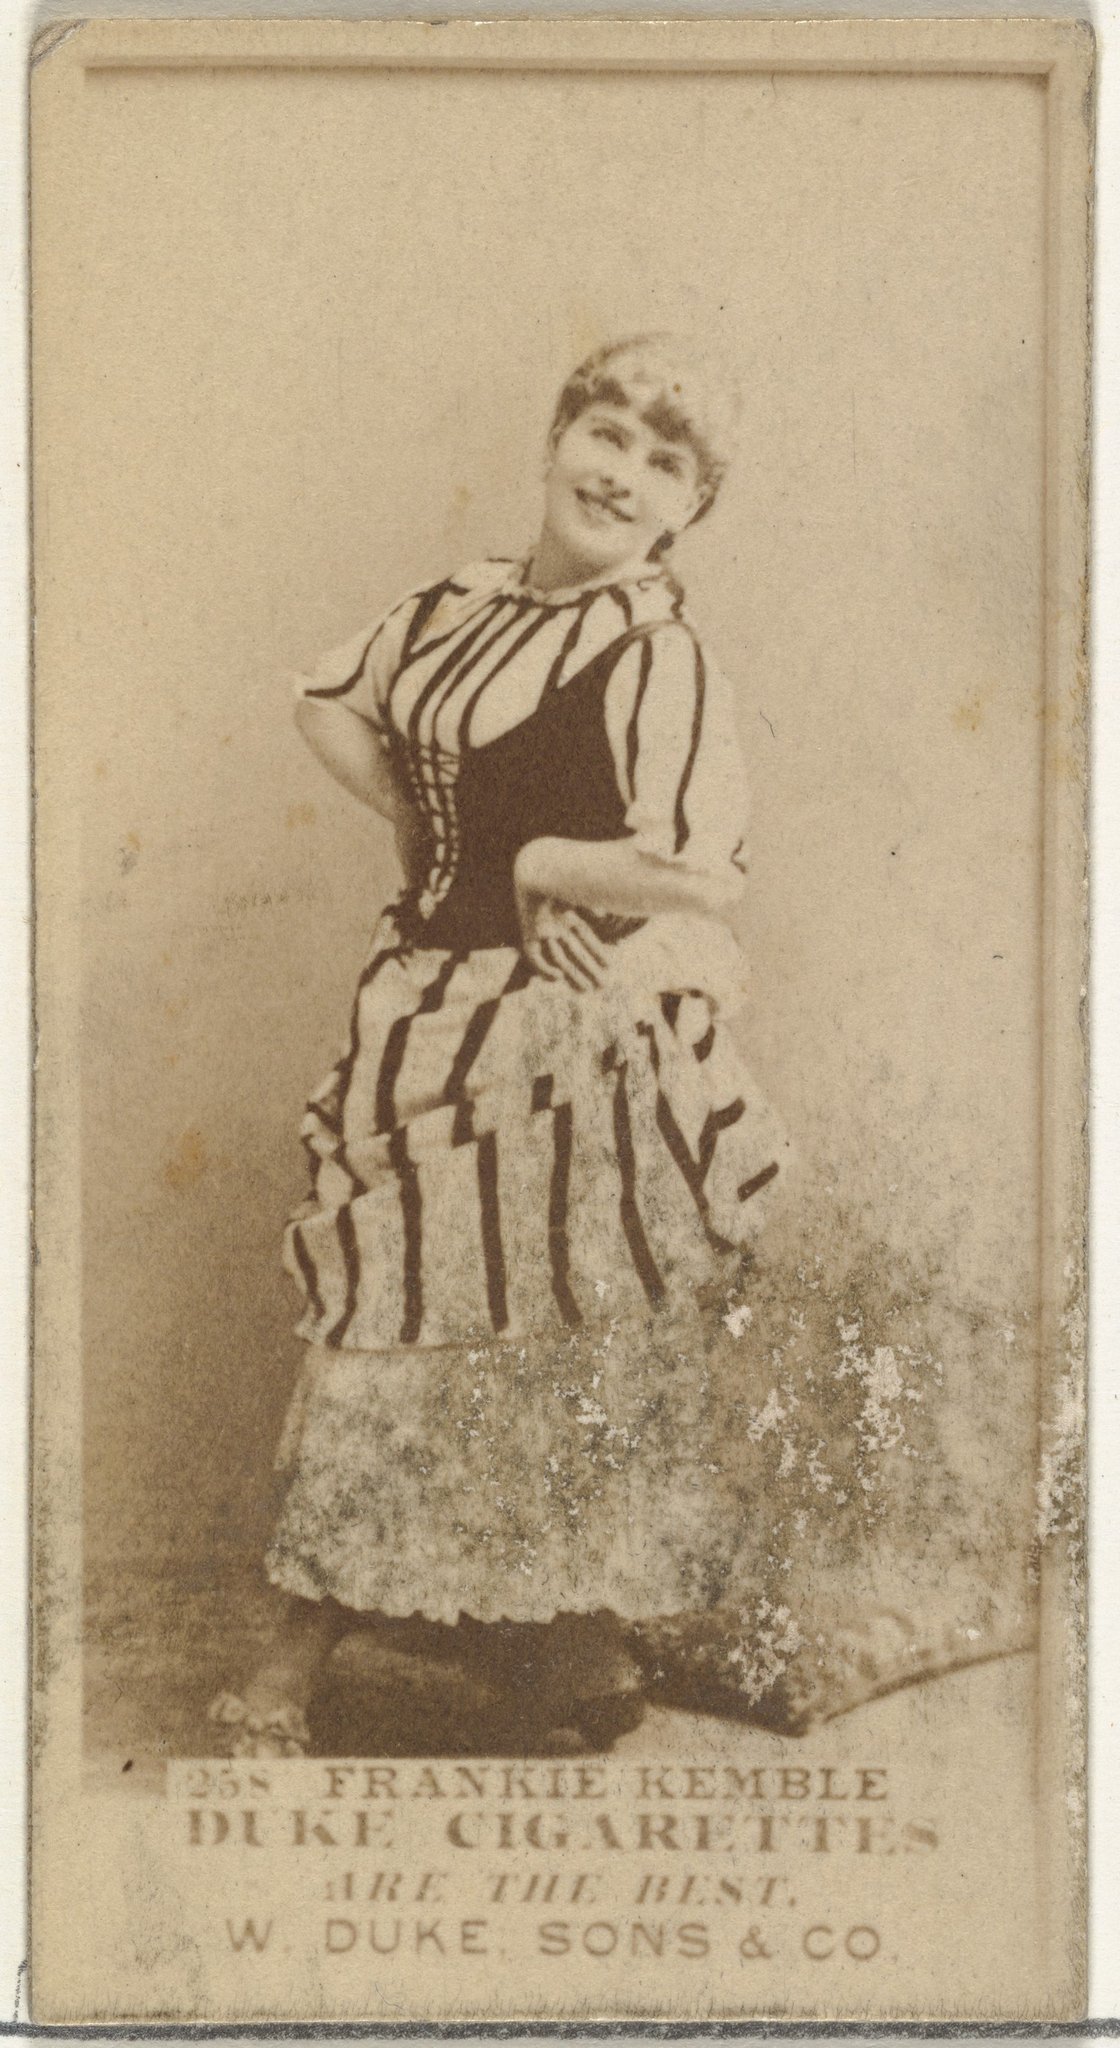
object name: photograph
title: Card Number 258, Frankie Kemble, from the Actors and Actresses series (N145-7) issued by Duke Sons & Co. to promote Duke Cigarettes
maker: w. duke, sons & co.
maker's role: publisher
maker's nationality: american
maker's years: 1870-1920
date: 1880-1889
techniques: albumen silver print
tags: portraits,women,actresses